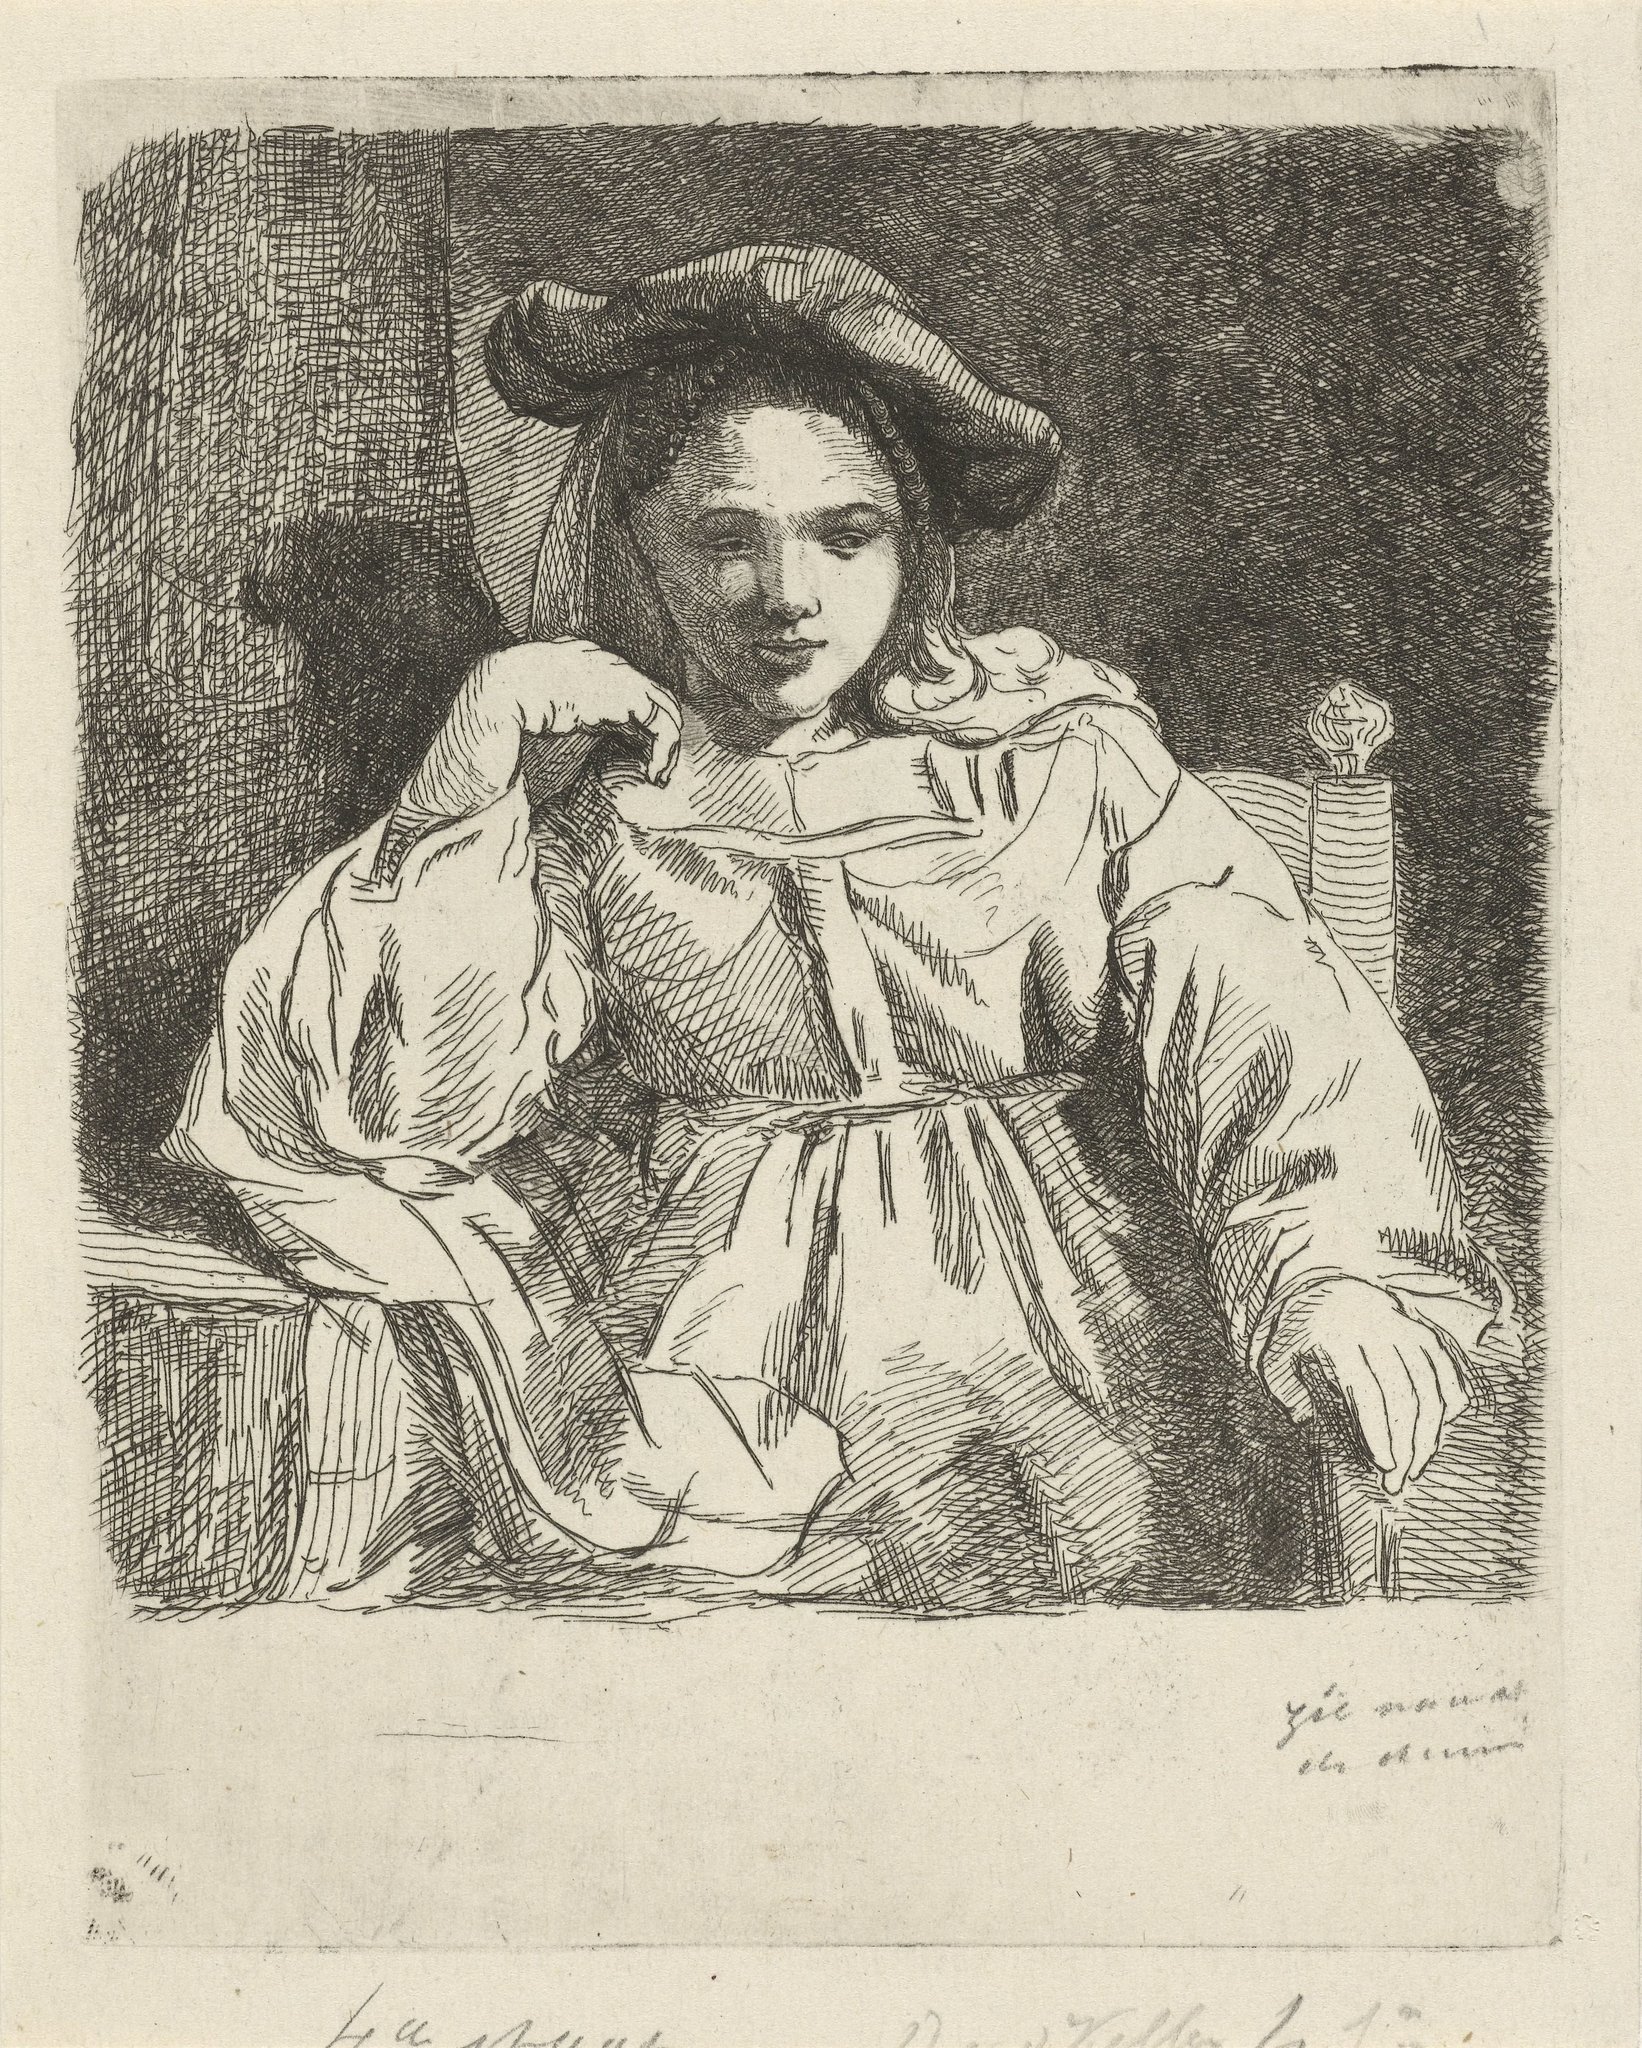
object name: print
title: Zittend meisje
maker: david van der kellen (1804-1879)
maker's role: die cutter, draughtsman, print maker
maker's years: 1804-1879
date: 1814-1859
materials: paper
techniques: drypoint, etching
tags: adolescent, young woman, maiden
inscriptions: collector's mark: Lugt 2228, inscription: ‘zie (...) en duim’, inscription: ‘4de in het (...) 5de staat ontbreekt (...)’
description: Een meisje, getooid met een baret, zit in een stoel, terwijl ze met haar elleboog op de tafel naast haar leunt.